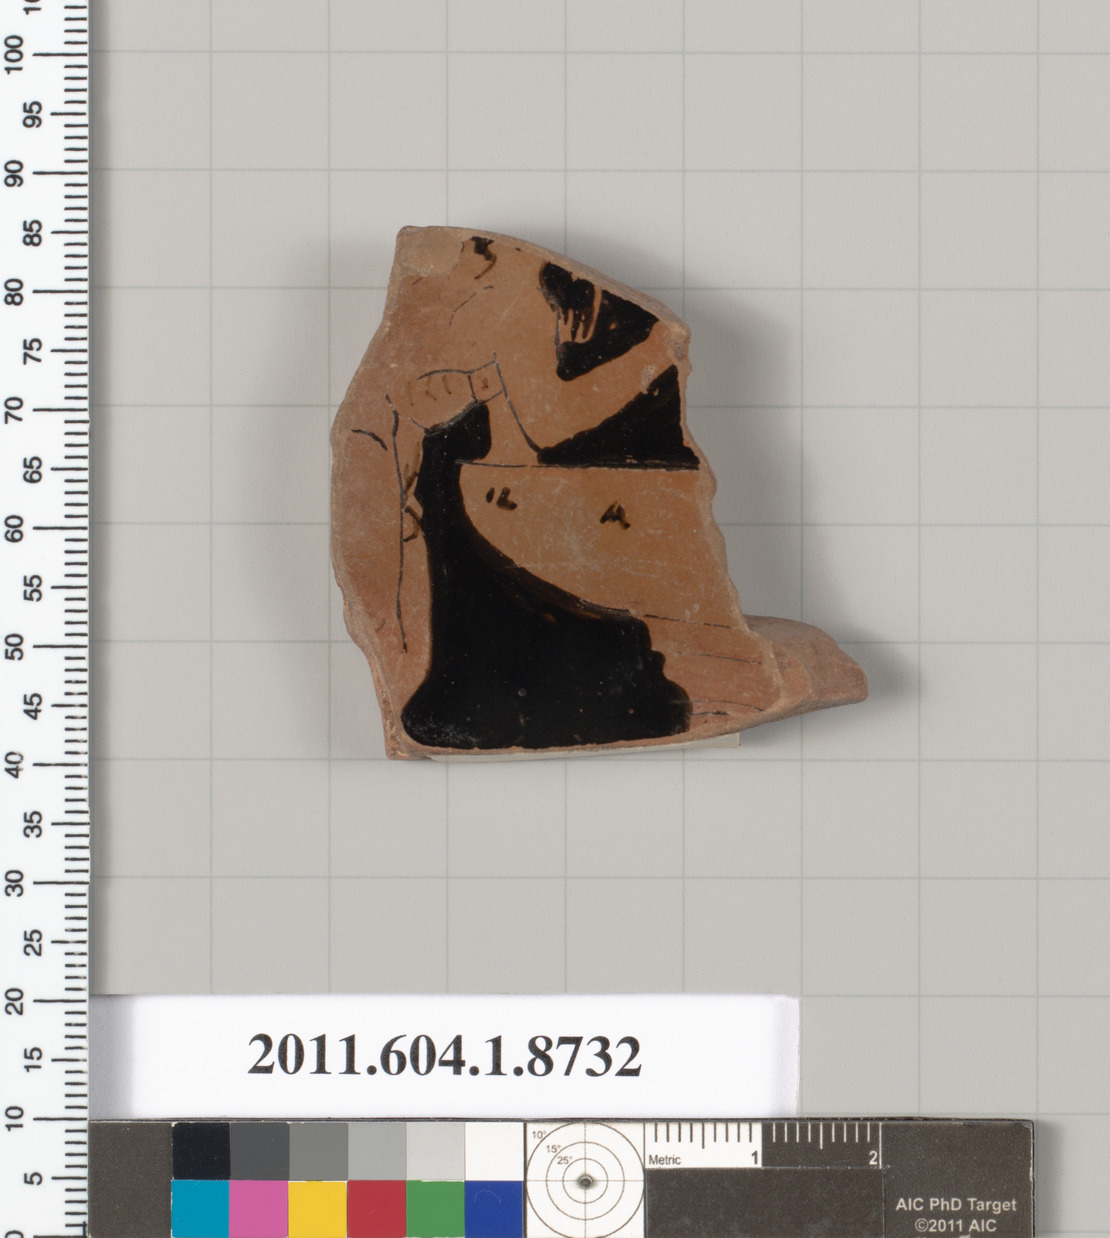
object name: kylix fragment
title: Terracotta fragment of a stemless cup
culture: greek, attic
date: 460-450 BCE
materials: terracotta